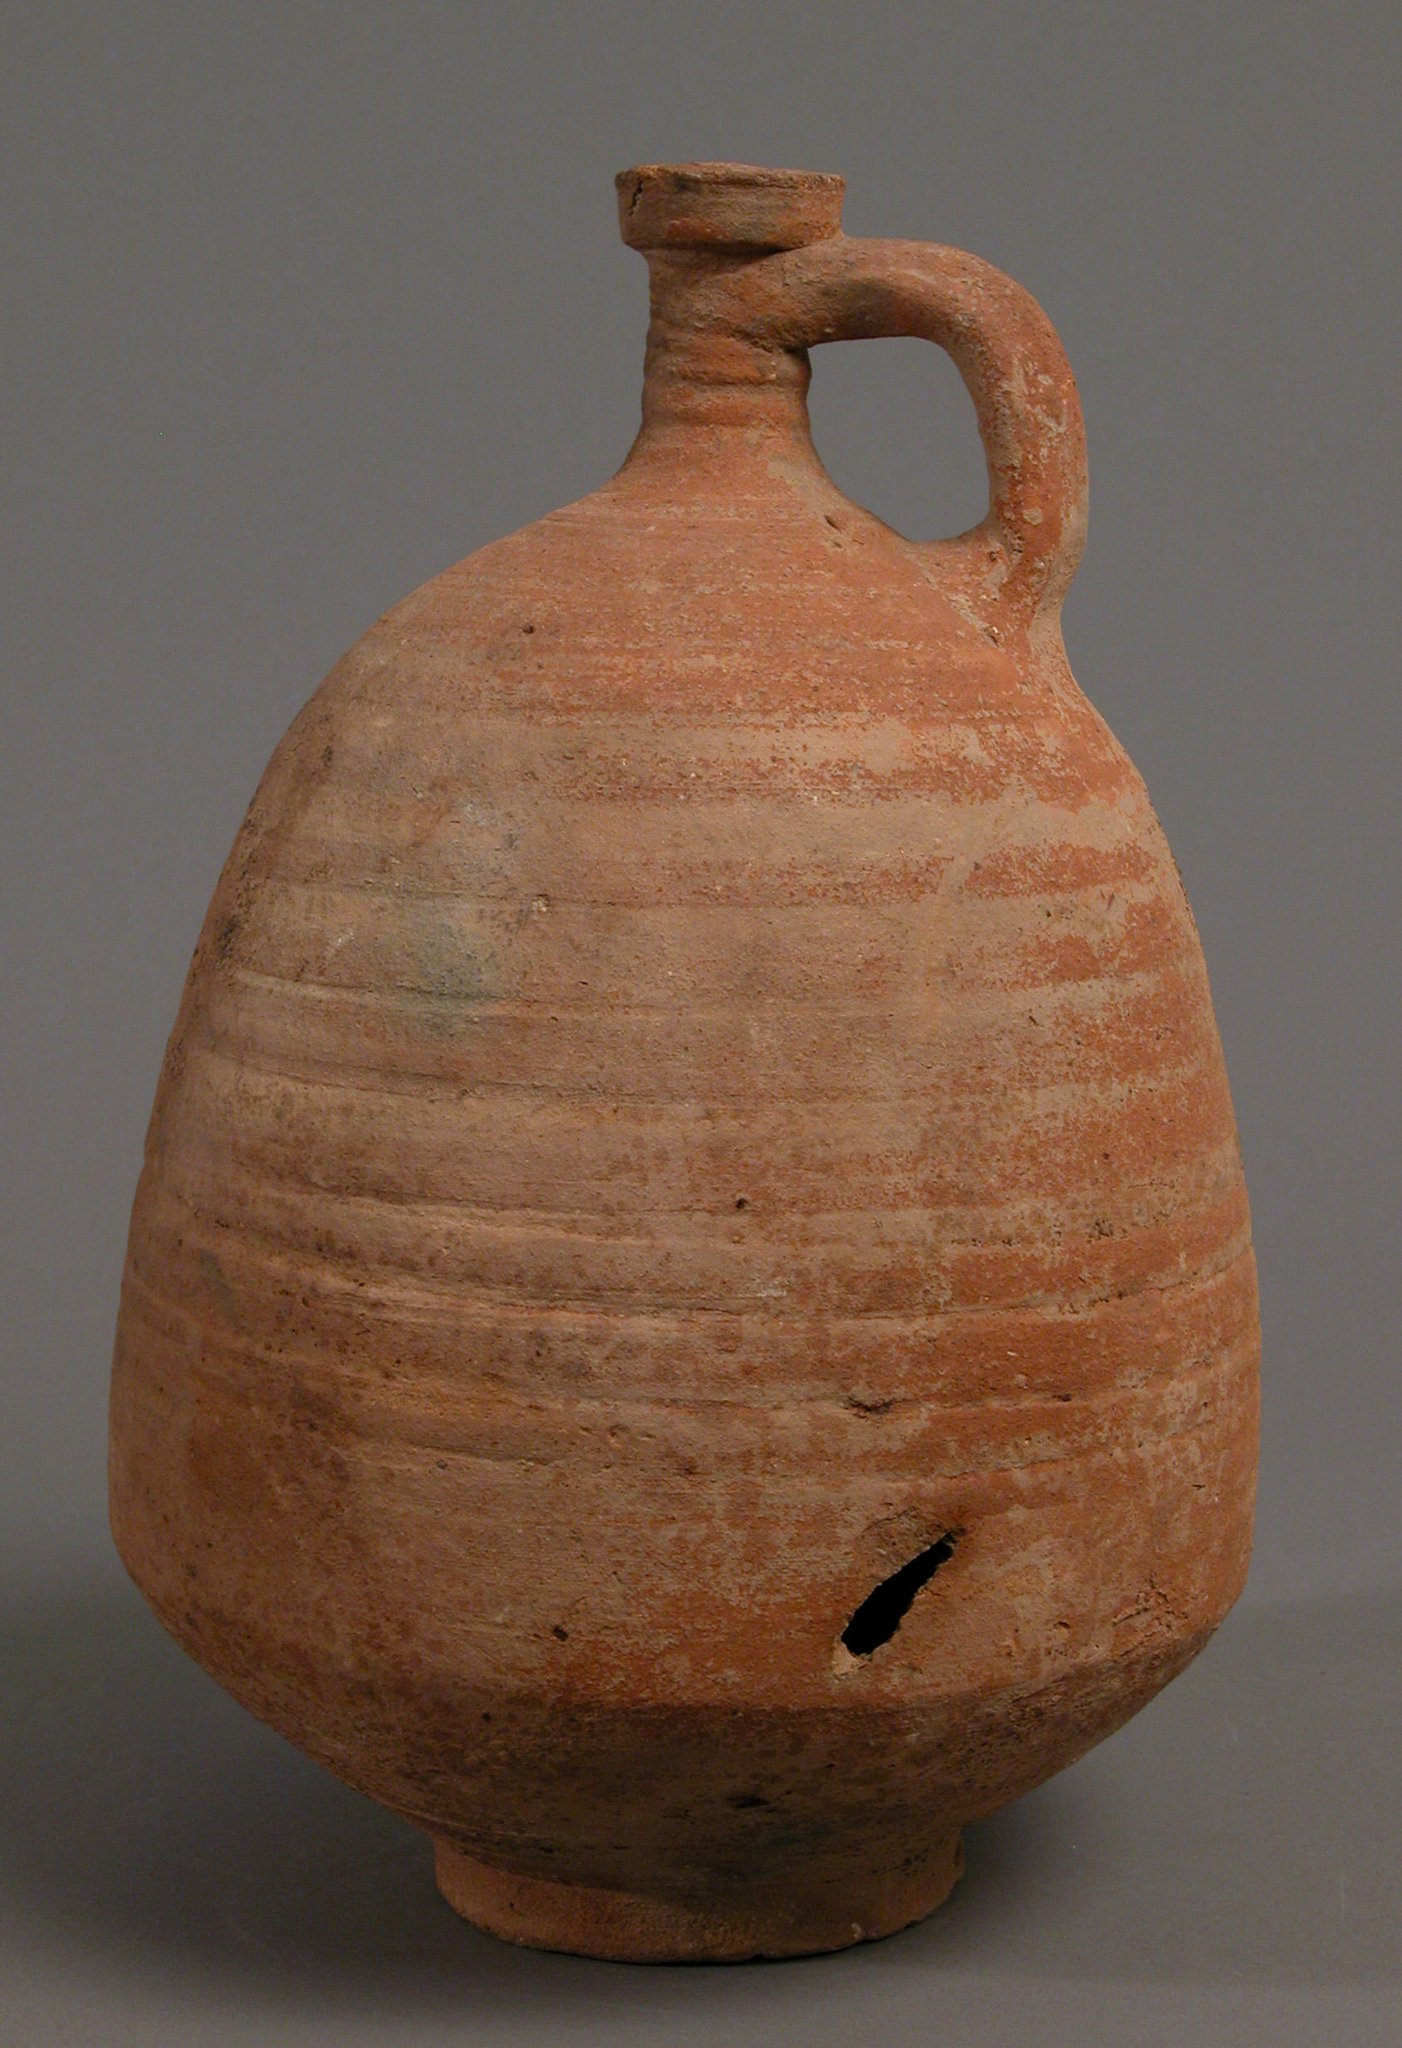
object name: jug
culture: coptic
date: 301-700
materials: earthenware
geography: egypt